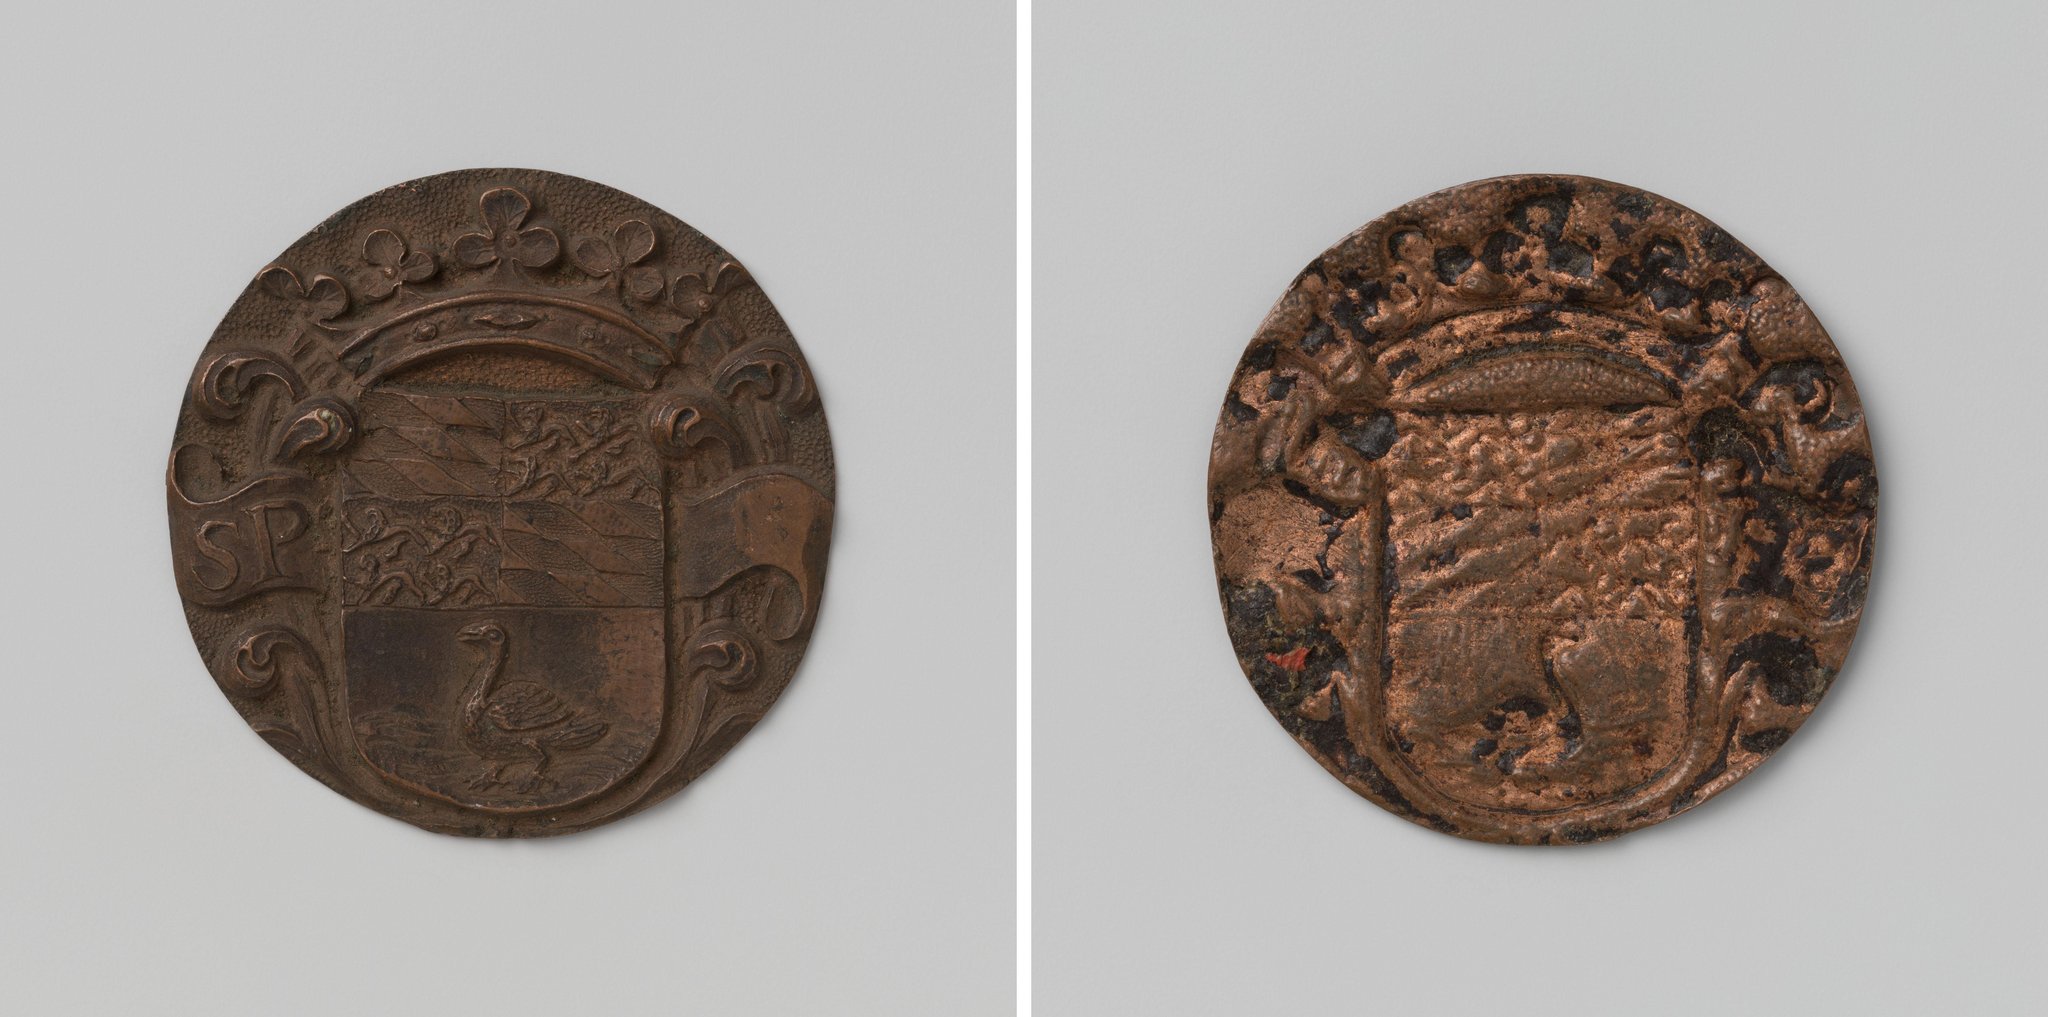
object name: copy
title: Goes, brandspuitpenning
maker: Anonymous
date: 1700-1850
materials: copper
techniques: casting, galvanization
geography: goes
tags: goes